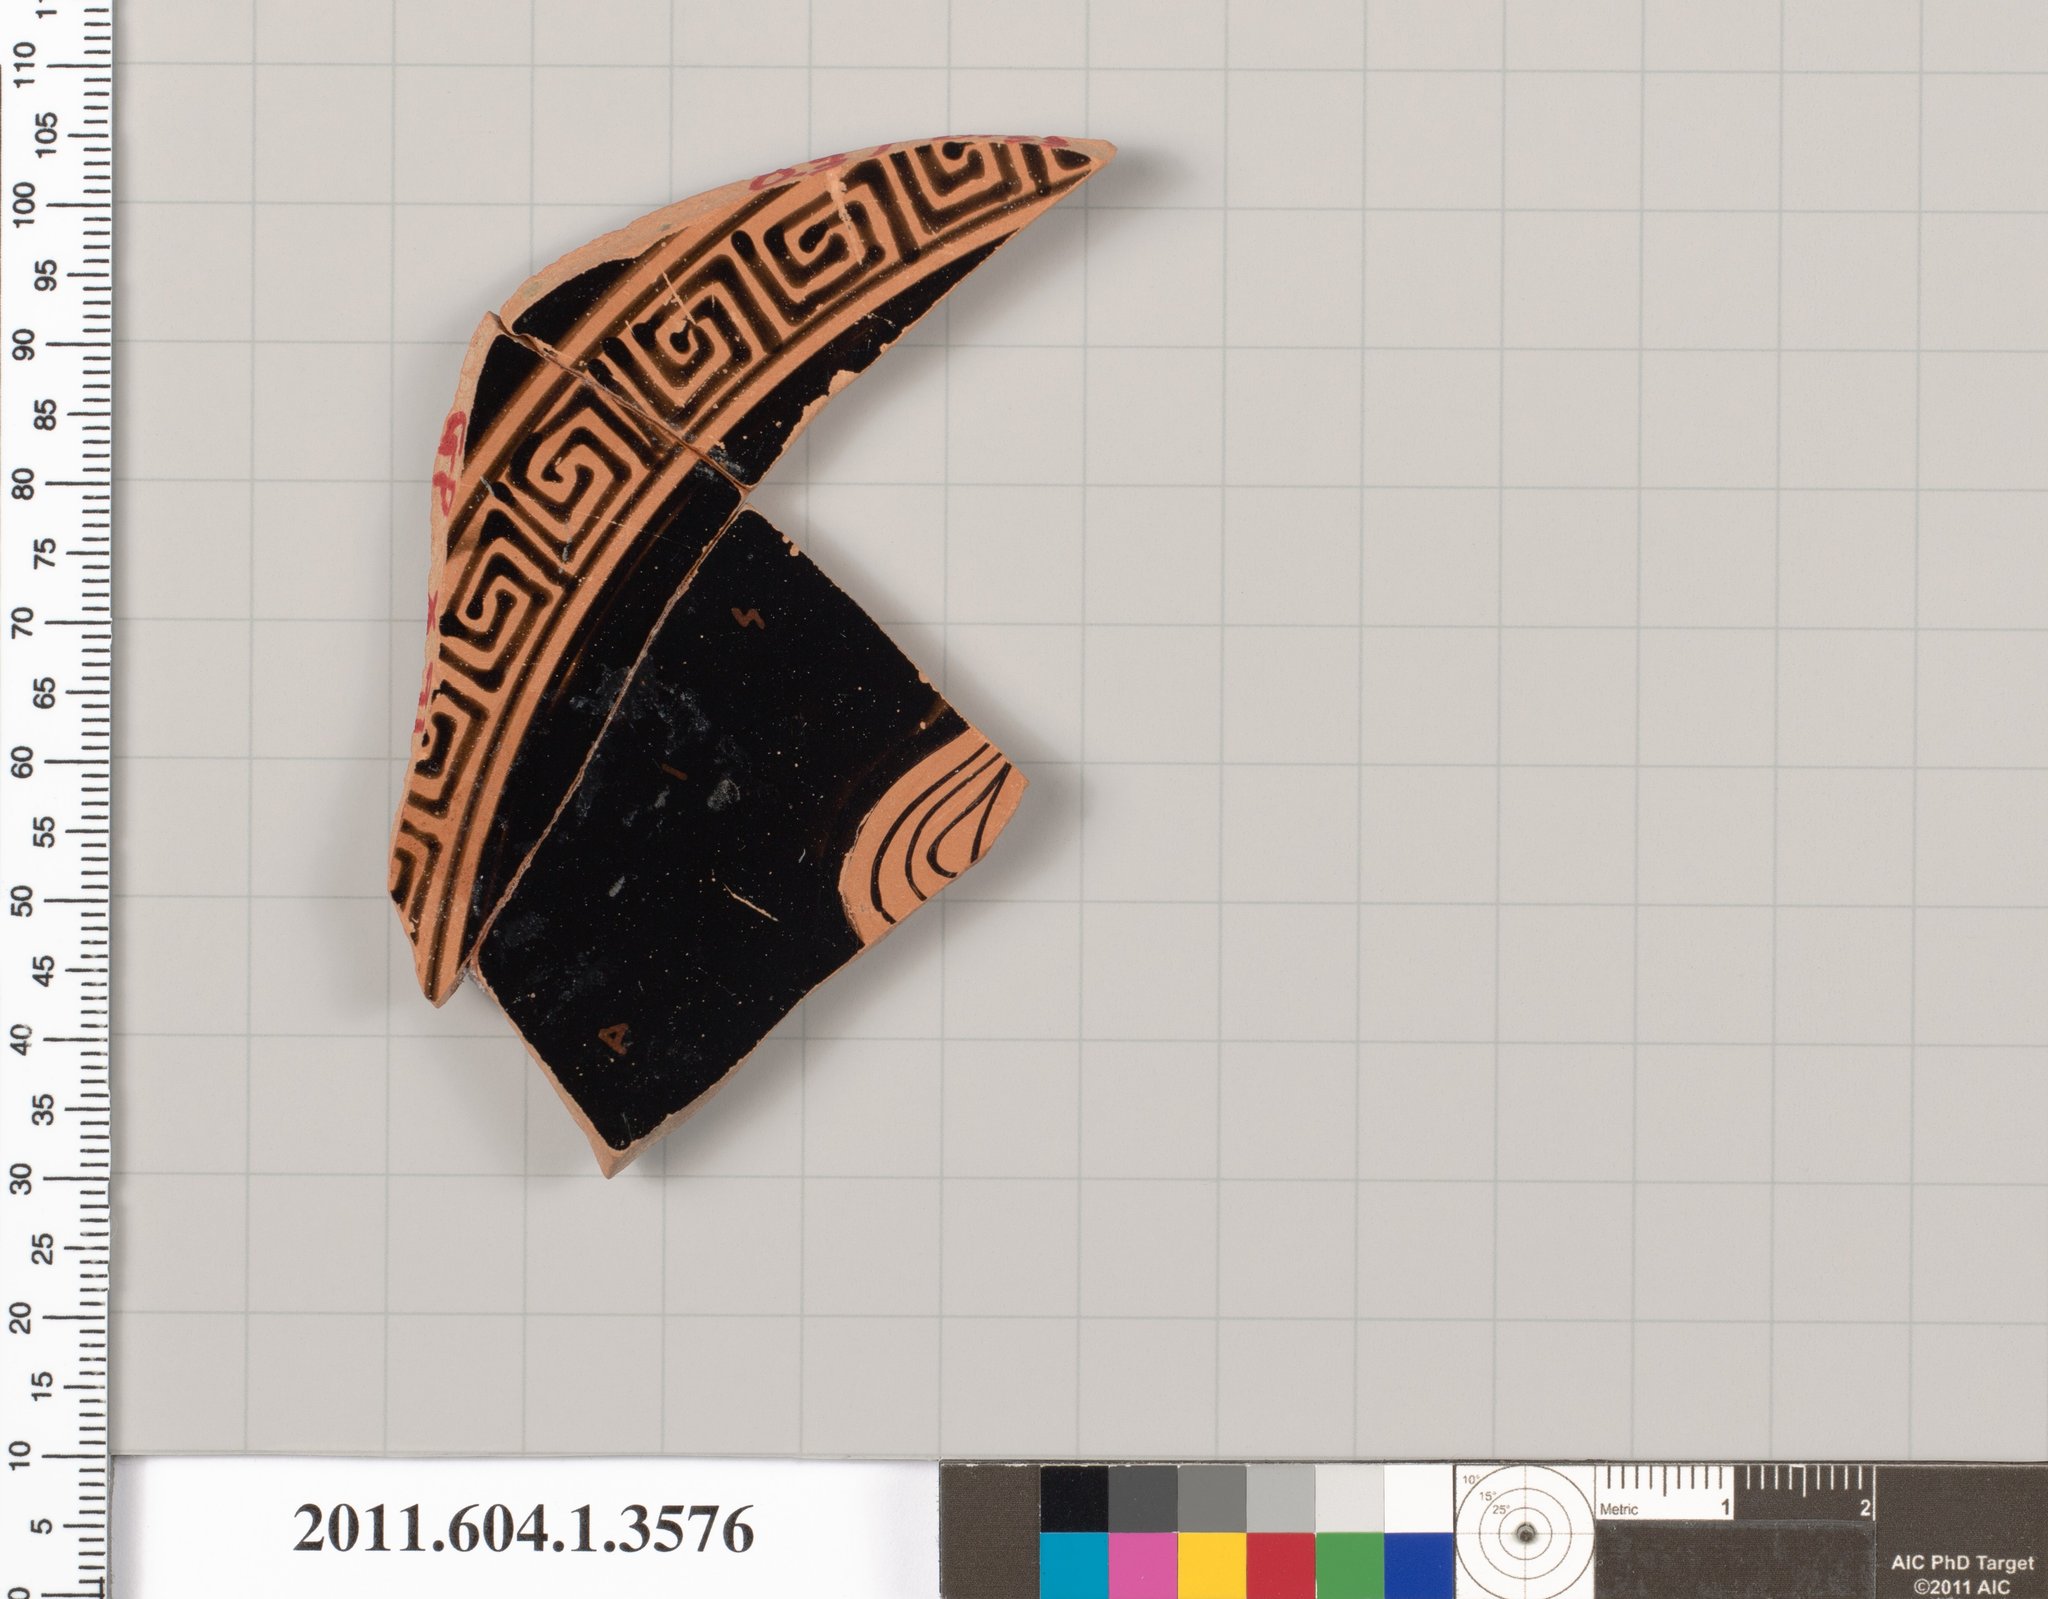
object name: kylix fragment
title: Terracotta fragment of a kylix (drinking cup)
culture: greek, attic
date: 490-480 BCE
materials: terracotta